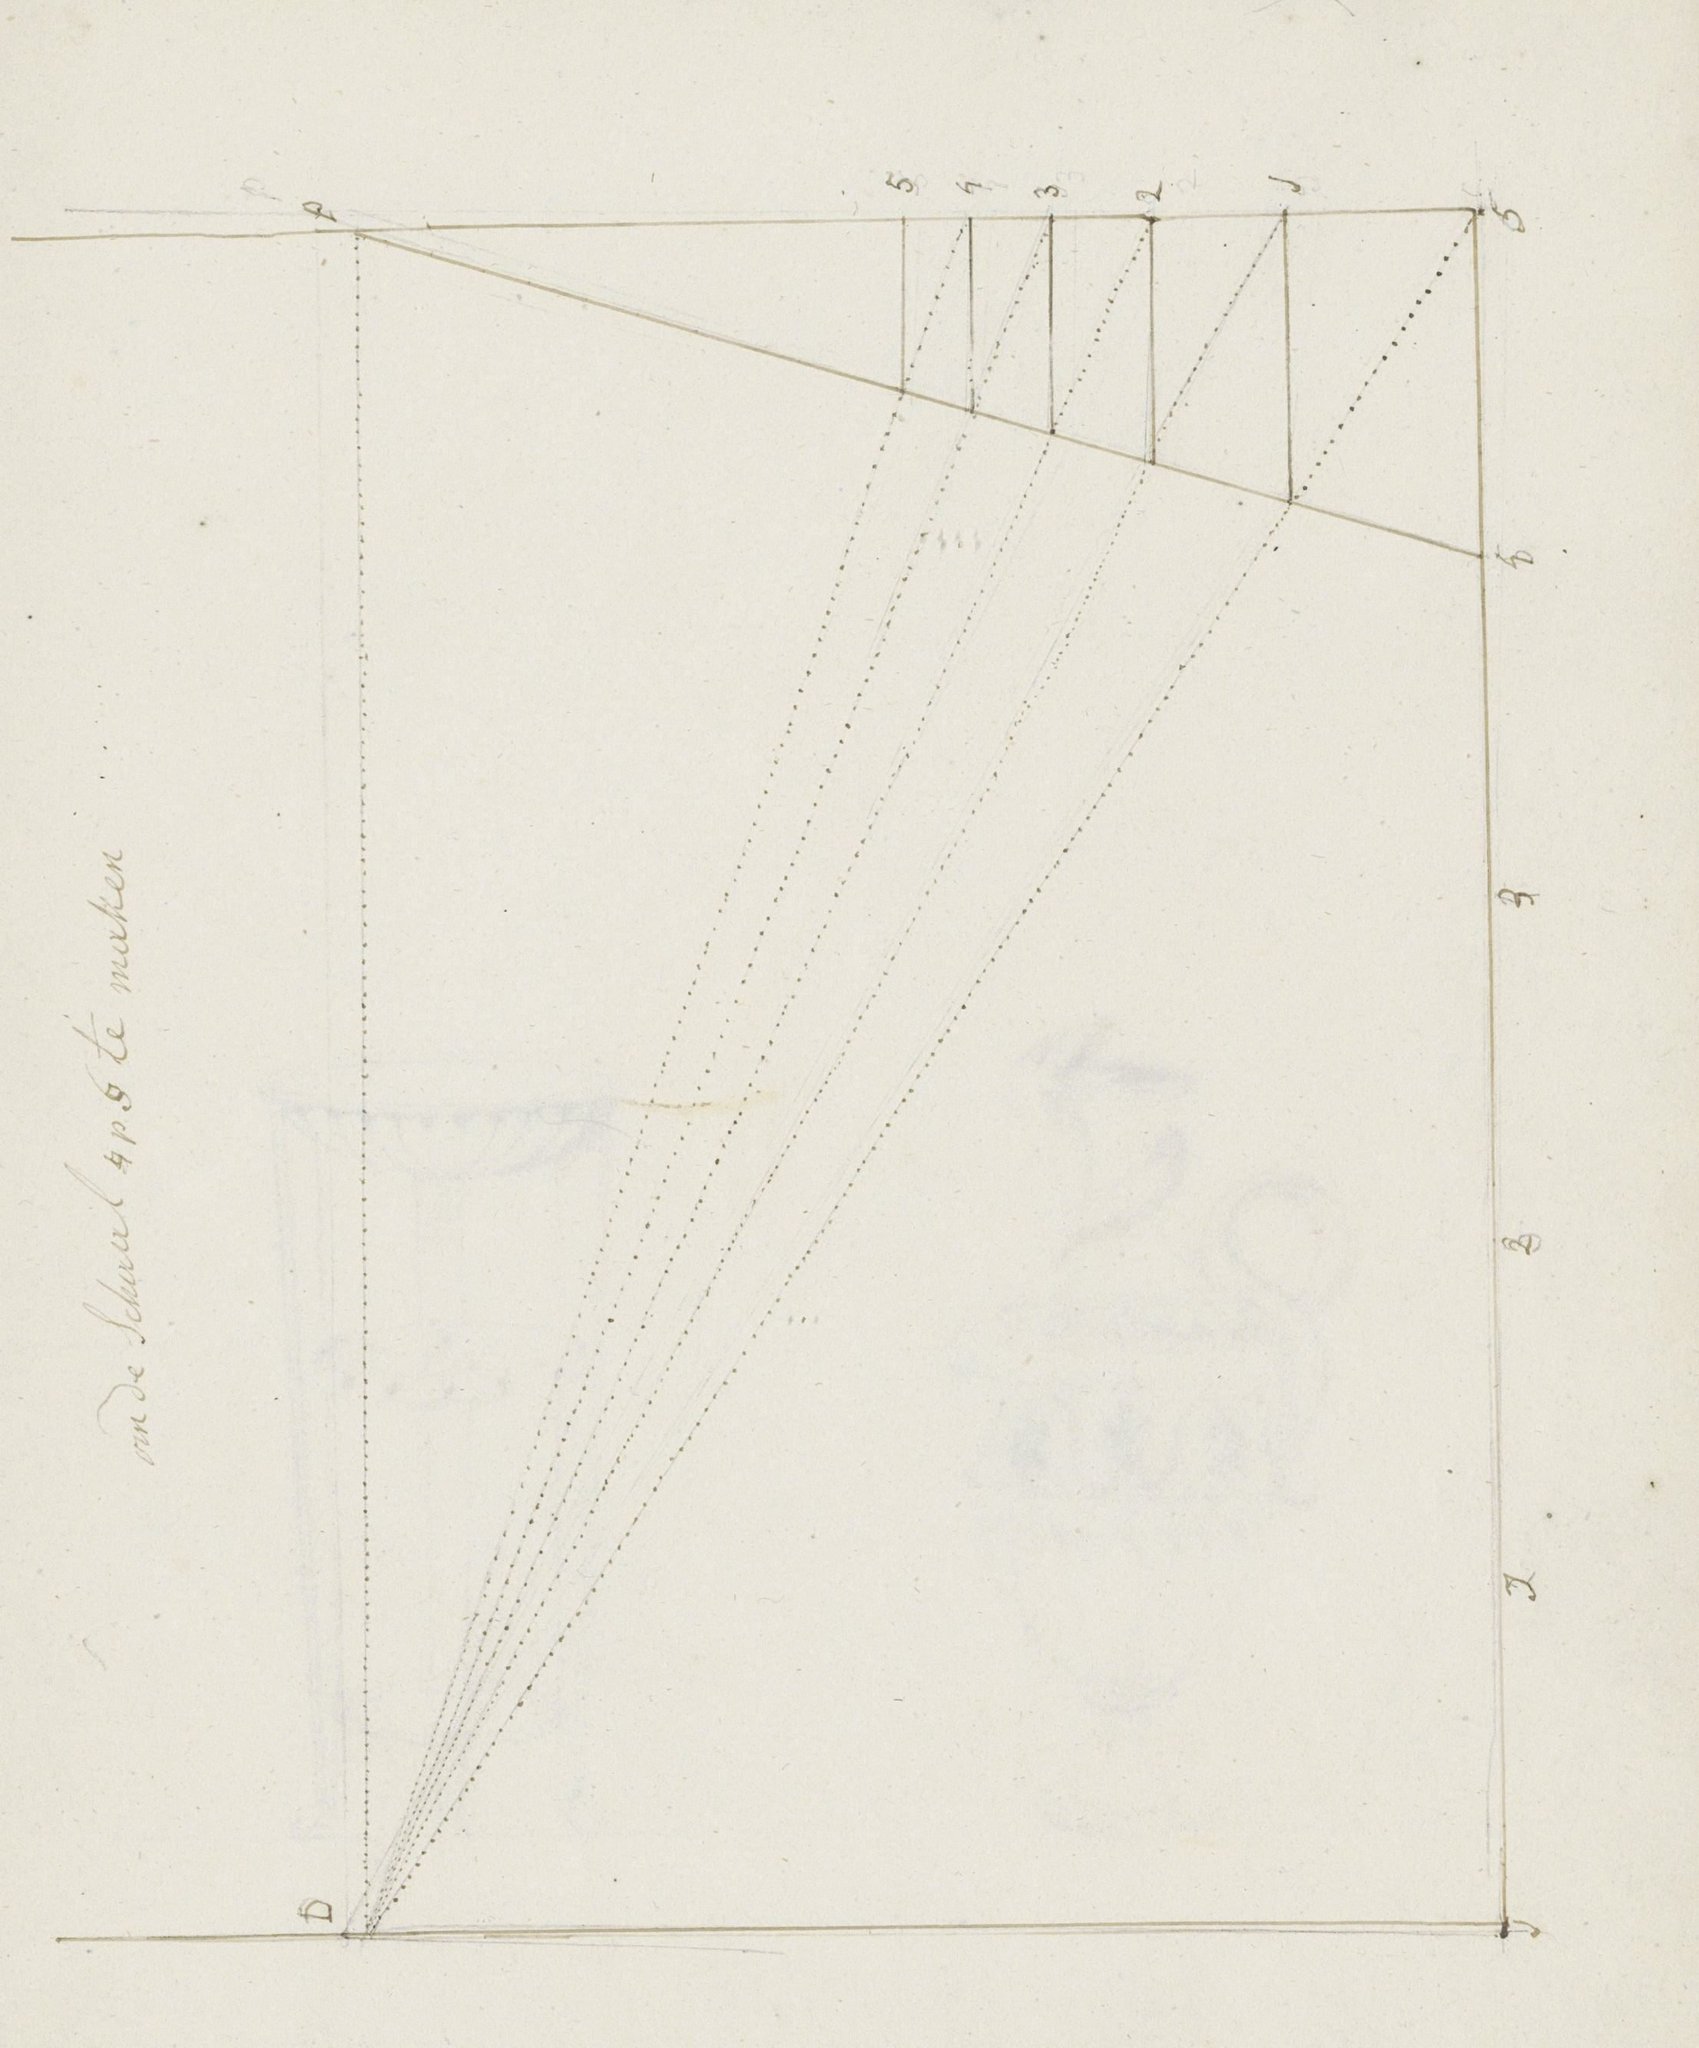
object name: sketchbook leaf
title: Perspectiefoefening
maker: jonkvrouw catharina kemper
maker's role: draughtsman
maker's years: 1801-1871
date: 1813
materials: ink, paper, pencil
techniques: pen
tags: mathematical perspective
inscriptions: annotation: ‘om de schaal 4p3 te maken’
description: Blad 7 recto uit een schetsboek met 91 bladen.